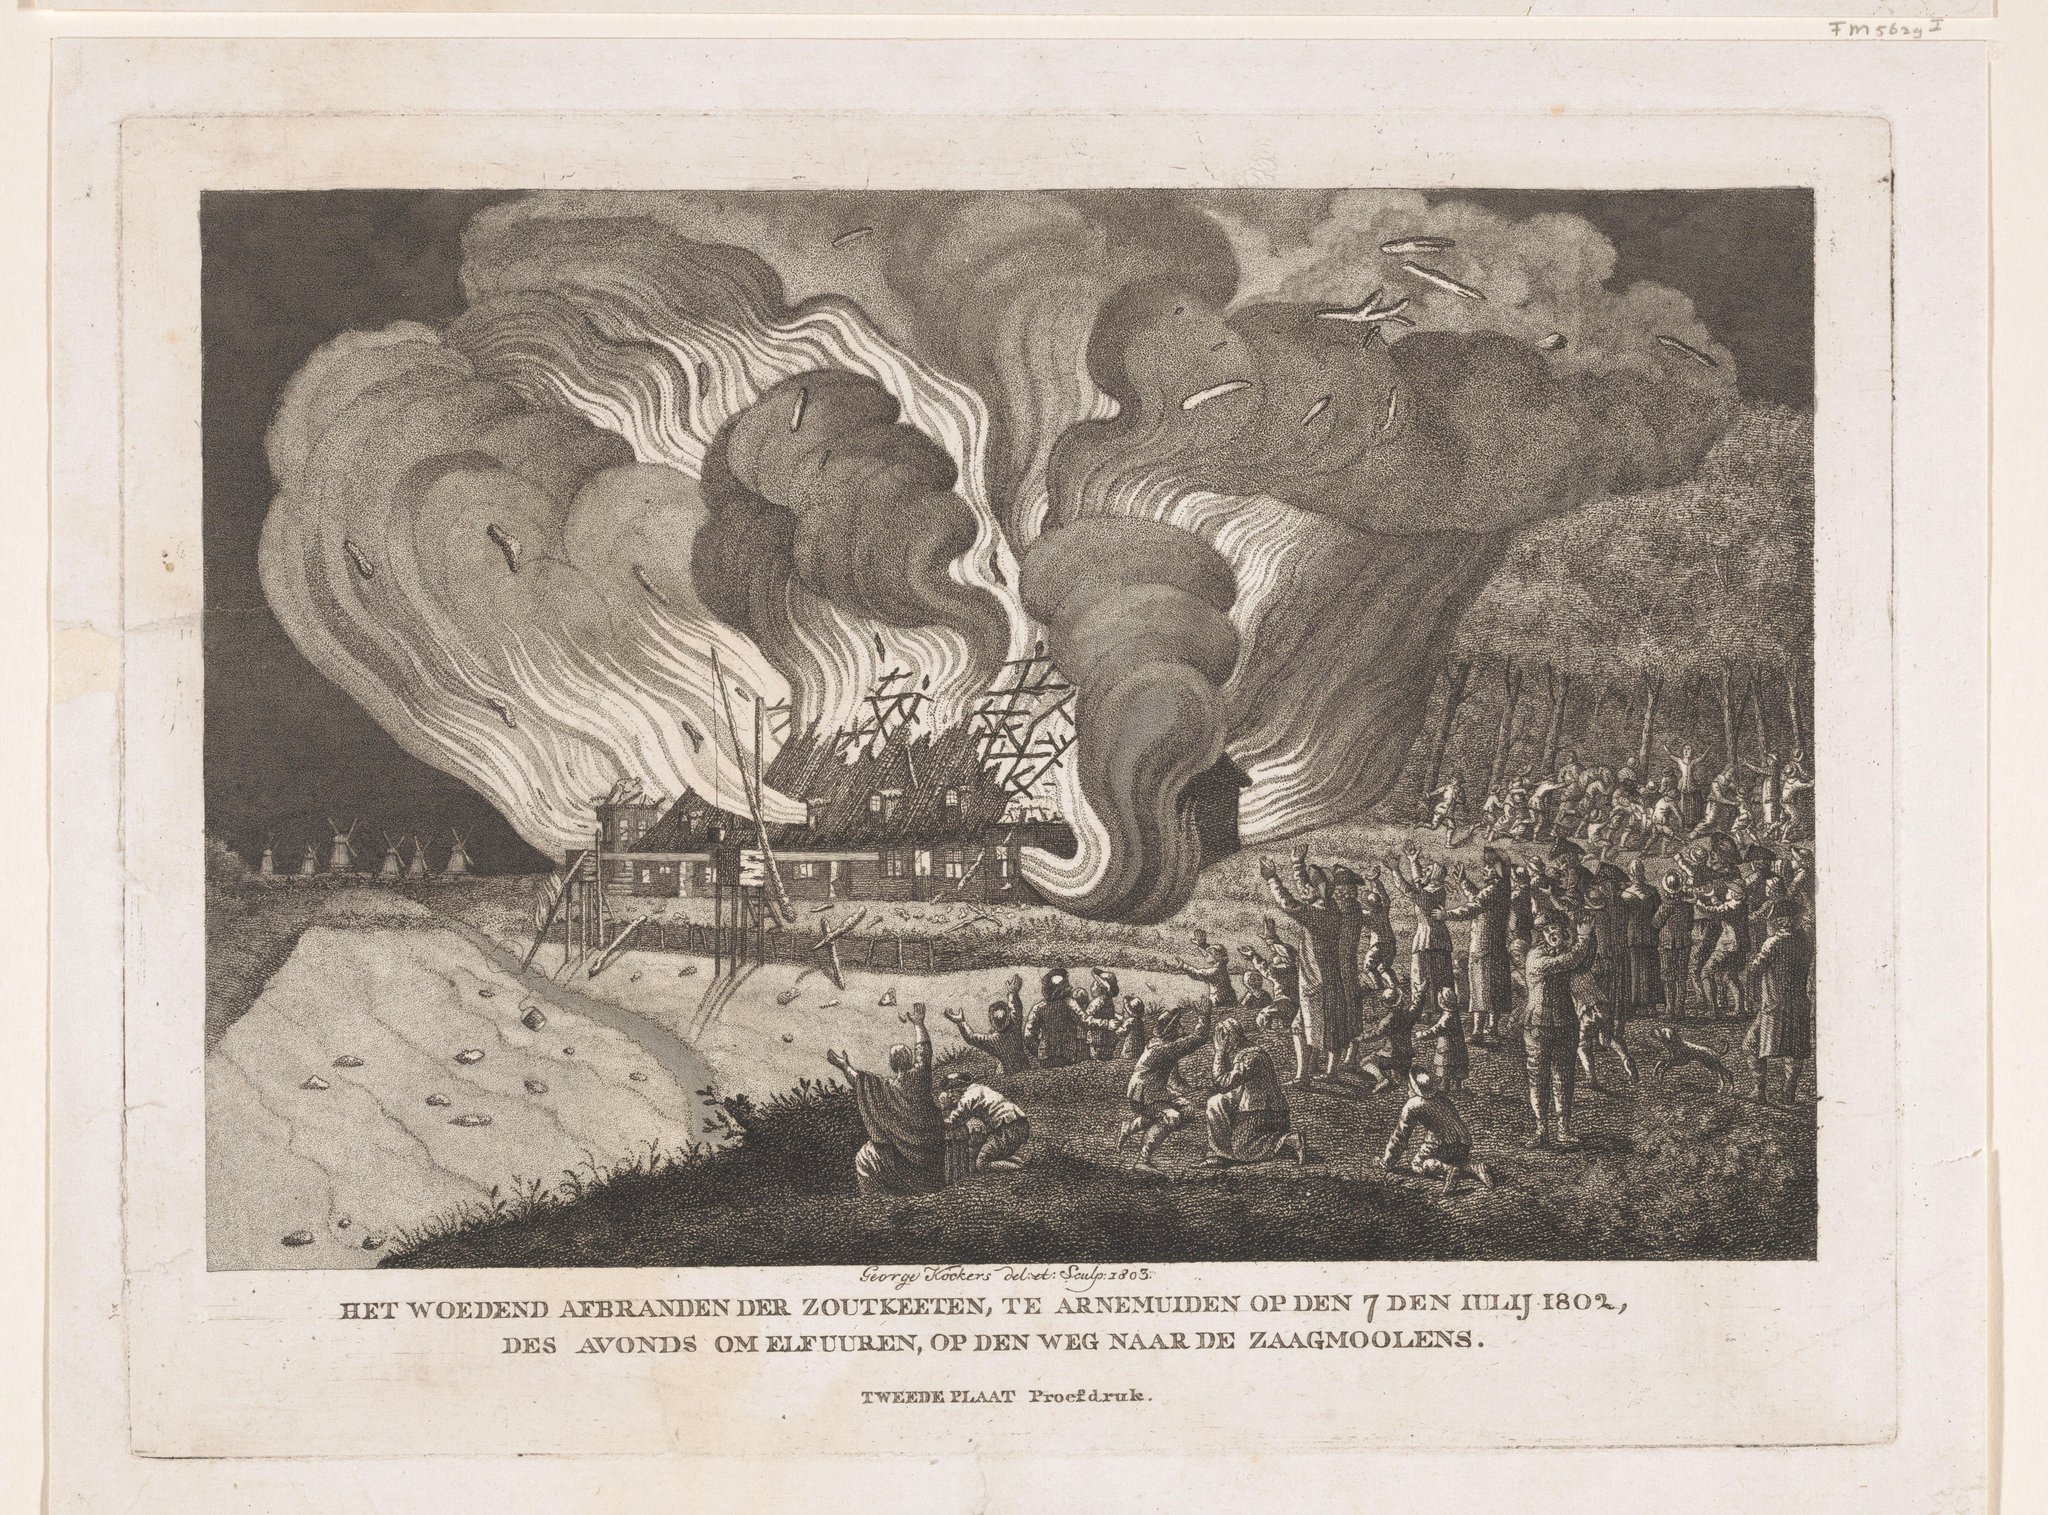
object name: print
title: Brand in Arnemuiden (plaat 2), 1802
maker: george kockers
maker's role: goldsmith, print maker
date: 1803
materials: paper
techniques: engraving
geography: netherlands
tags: on fire, ablaze, pump (fire-extinguishing equipment)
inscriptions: collector's mark: Lugt 2228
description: Grote brand in Arnemuiden op 7 juli 1802 waarbij verschillende zoutketen zijn afgebrand. Menigte toeschouwers kijkt ontzet toe. Zie ook de pendant.